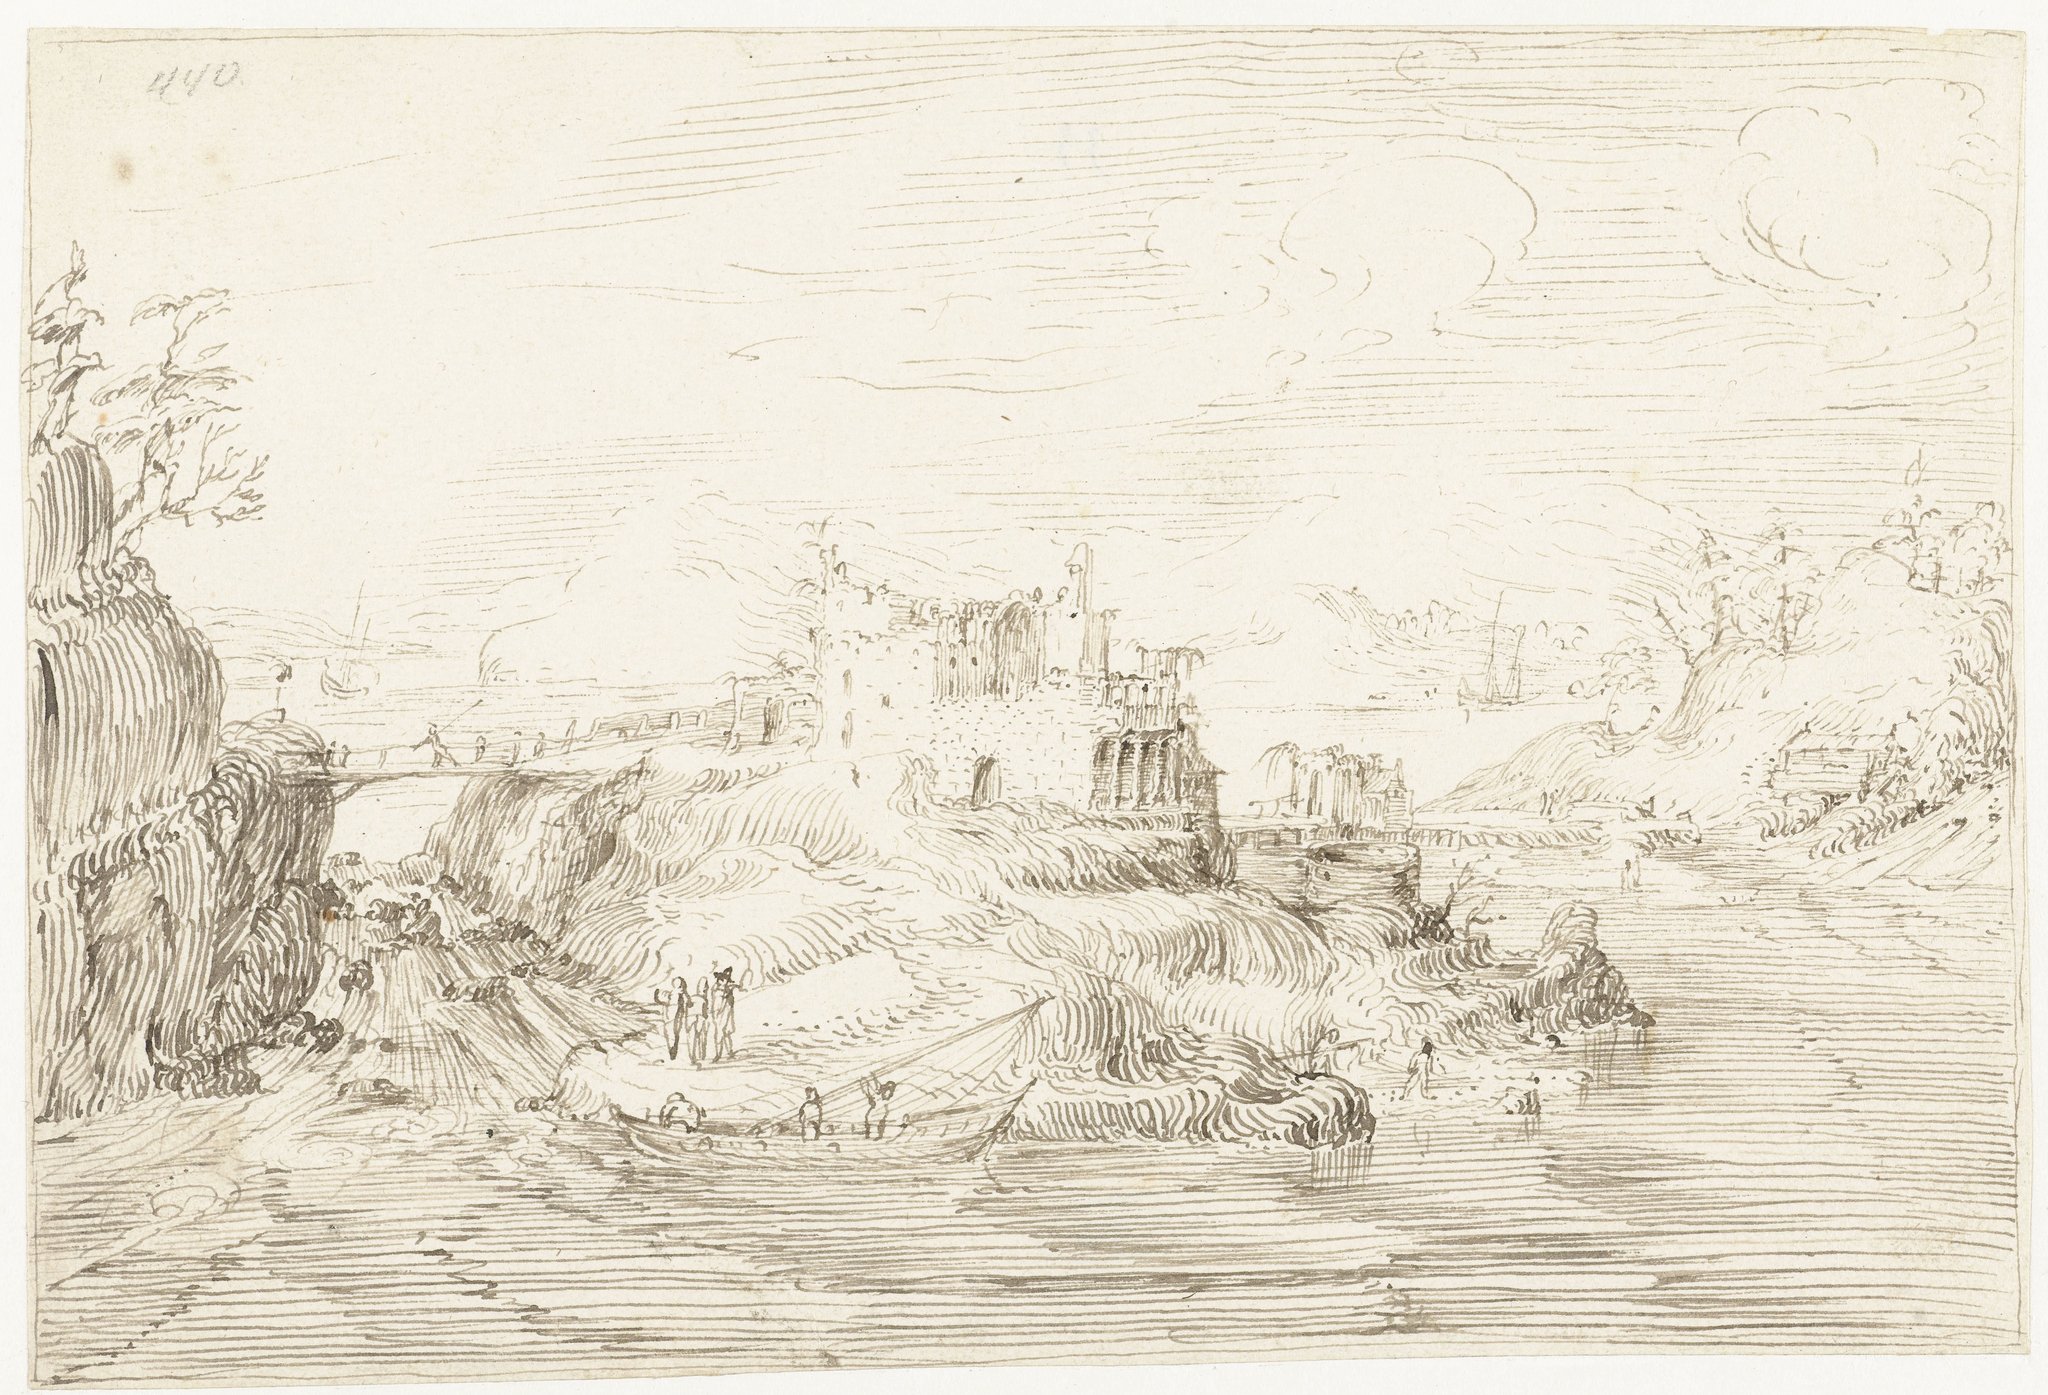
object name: drawing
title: Kustlandschap met ruïnes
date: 1590-1633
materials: ink, paper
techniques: pen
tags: ruin of a building ~ architecture, coast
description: Drawings from the Ter Borch Studio Estate [2 dln.]. Catalogus van de Nederlandse tekeningen in het Rijksprentenkabinet, Amsterdam. Dl. V, 1988; dl. 2, p 773